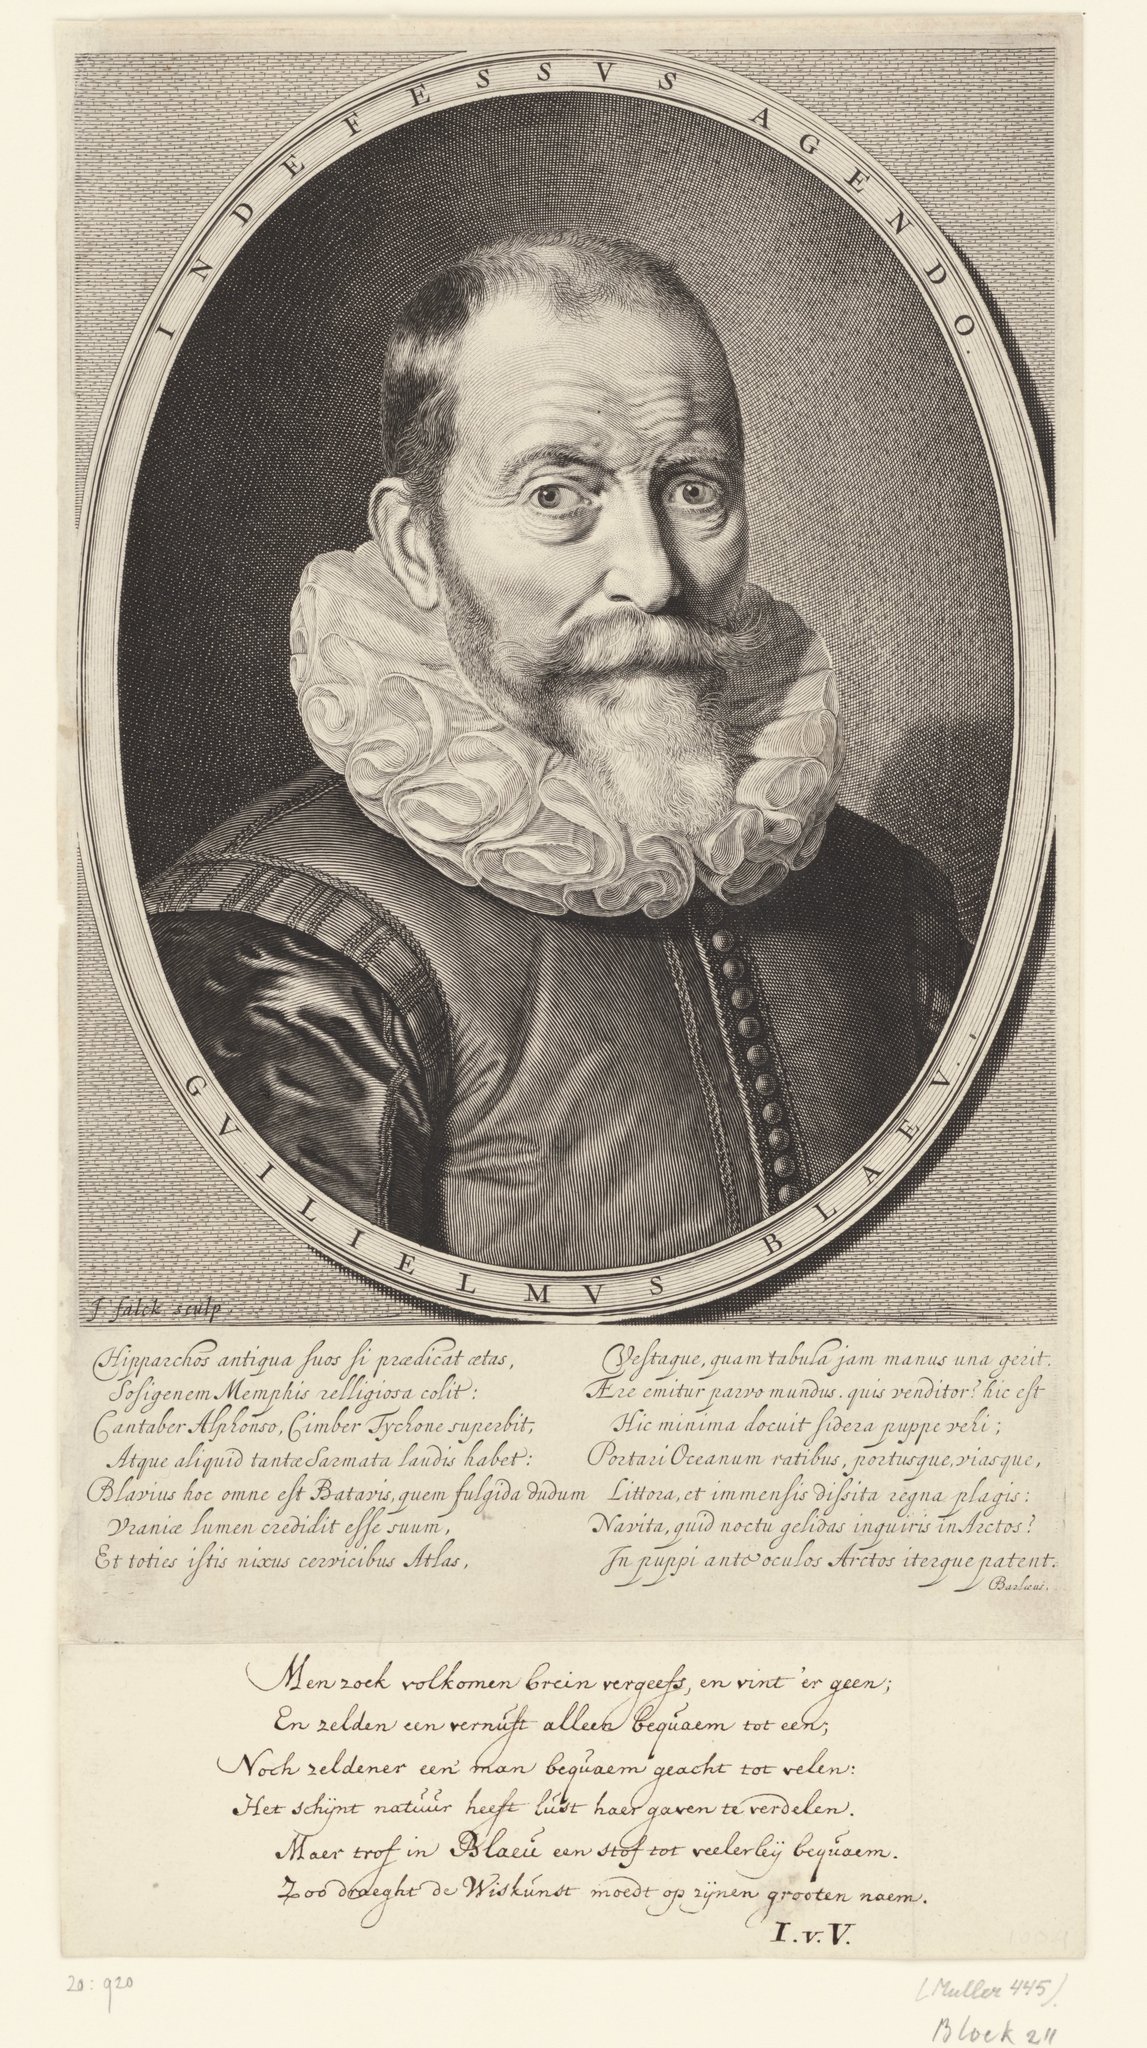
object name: print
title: Portret van Willem Jansz. Blaeu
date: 1655-1677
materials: paper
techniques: engraving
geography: amsterdam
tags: amsterdam, print maker, publisher, willem janszoon blaeu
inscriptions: collector's mark: Lugt 2228, inscription: ‘Men zoek volkomen brein vergeefs, en vint 'er geen; En zeldemn een vernuft alleen bequaem tot een; Nich zeldener een' man bequaem geacht tot velen; Het schijnt natuur heeft lust haer gaven te verdelen. Maer trof in Blaeu een stof tot veelerleij bequaem. Zoo draeght de Wiskunst moedt op zijnen grooten naem. I.v.V.’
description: Portret van de Nederlandse cartograaf en globemaker Willem Jansz. Blaeu. Ten halven lijve afgebeeld in ovale omlijsting. Onder de lijst een opschrift in Latijn en bijgevoegd een handgeschreven Nederlands vers van zes regels.